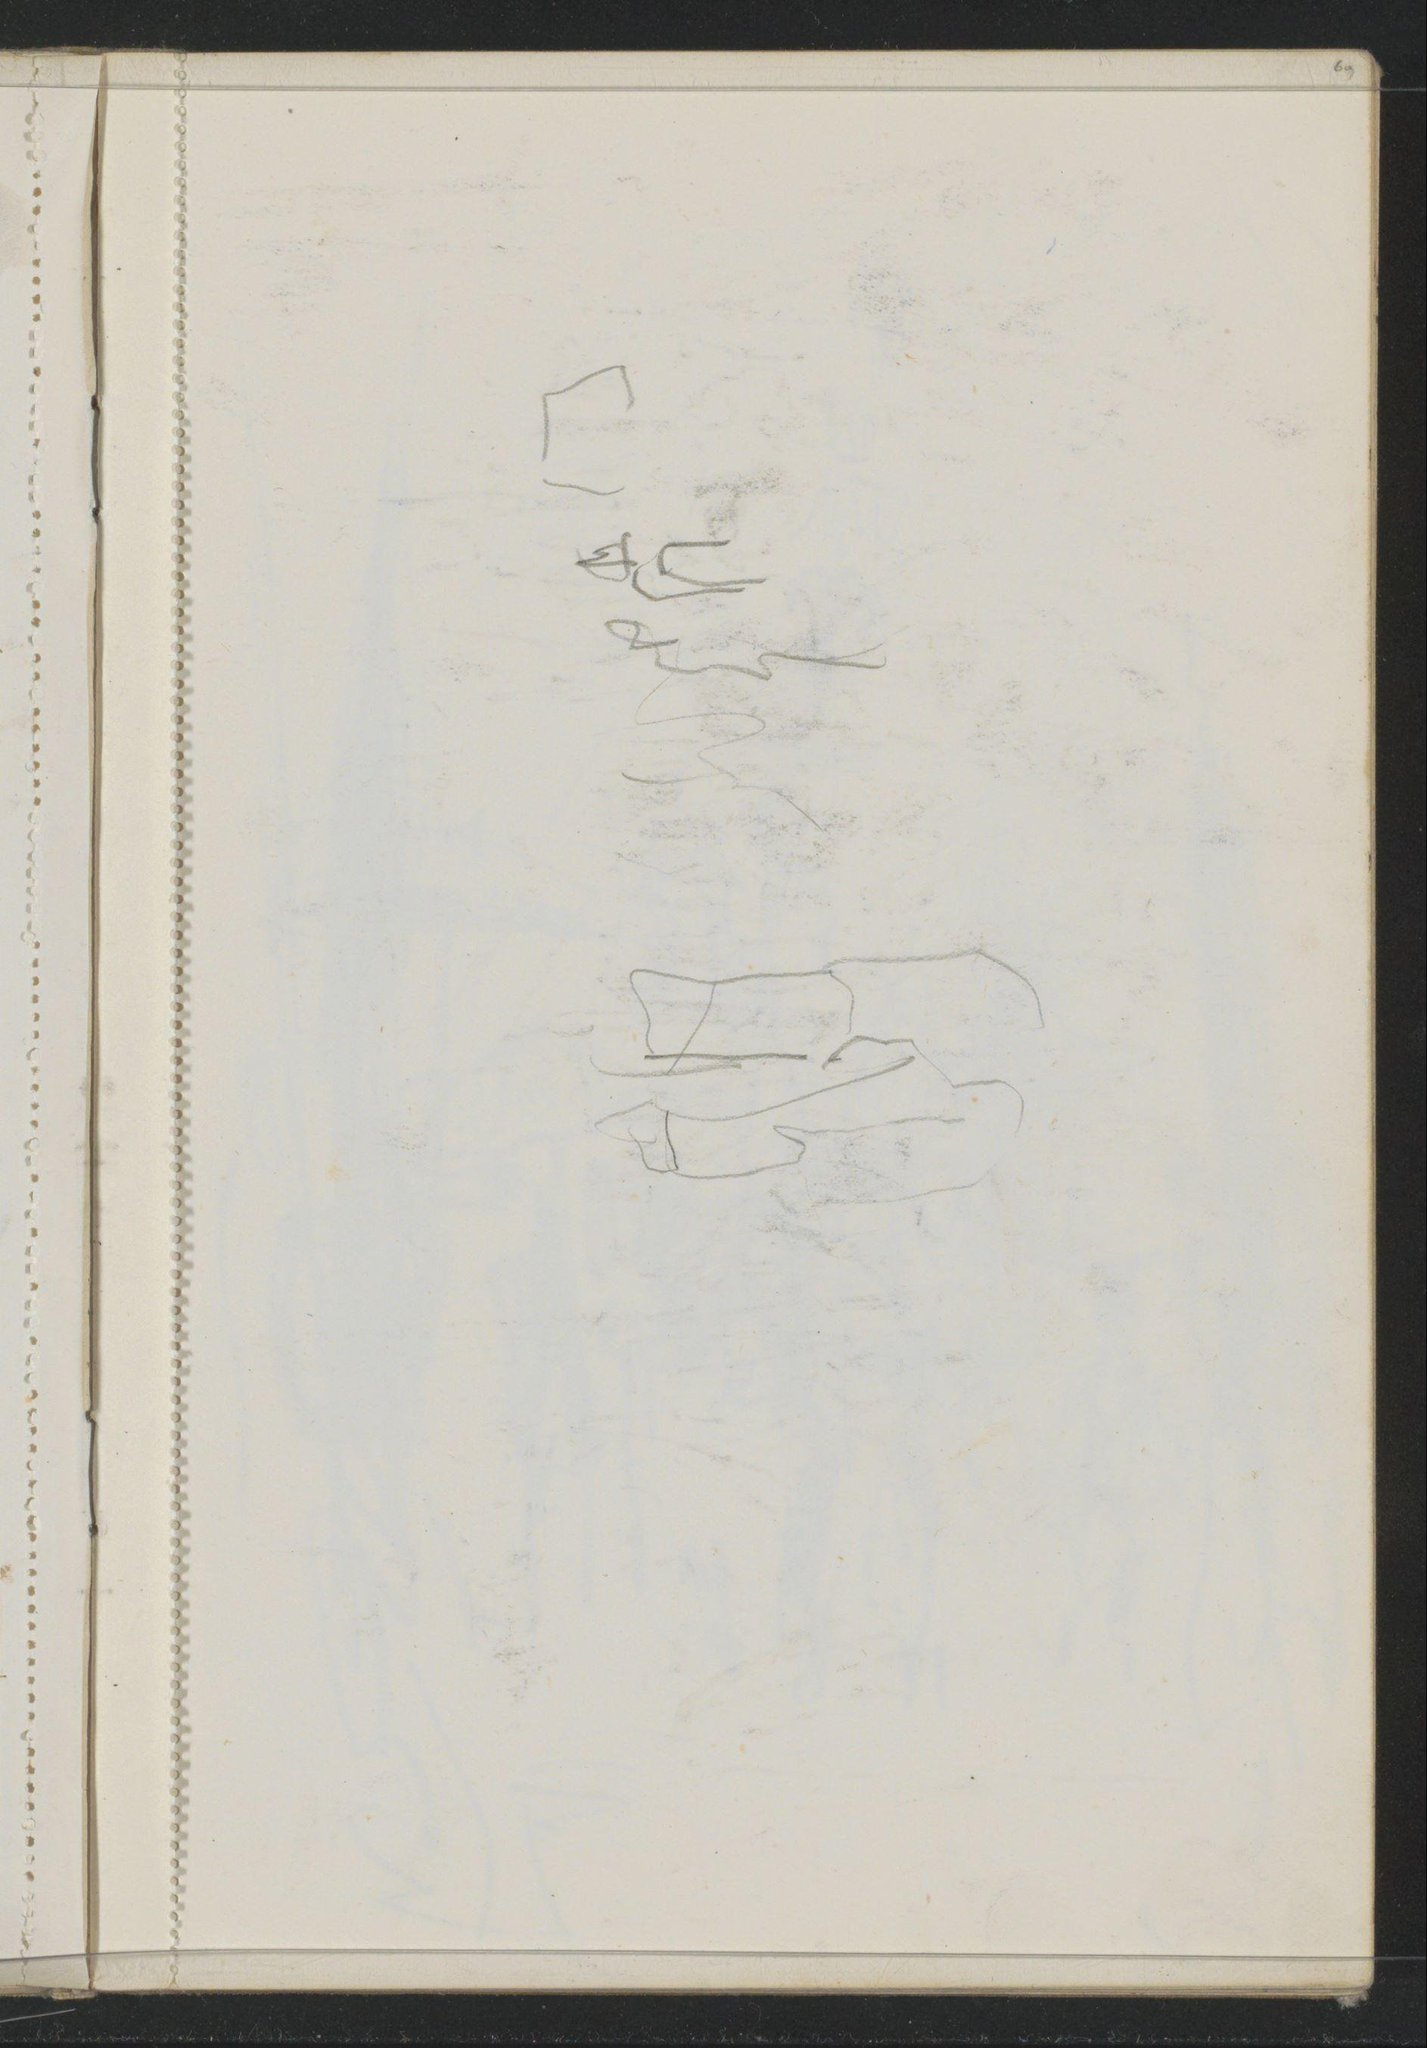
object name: sketchbook leaf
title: Studie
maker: marius bauer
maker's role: draughtsman, print maker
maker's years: 1867-1932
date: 1925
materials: paper, pencil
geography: indonesia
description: Pagina 69 uit een schetsboek met 74 bladen.